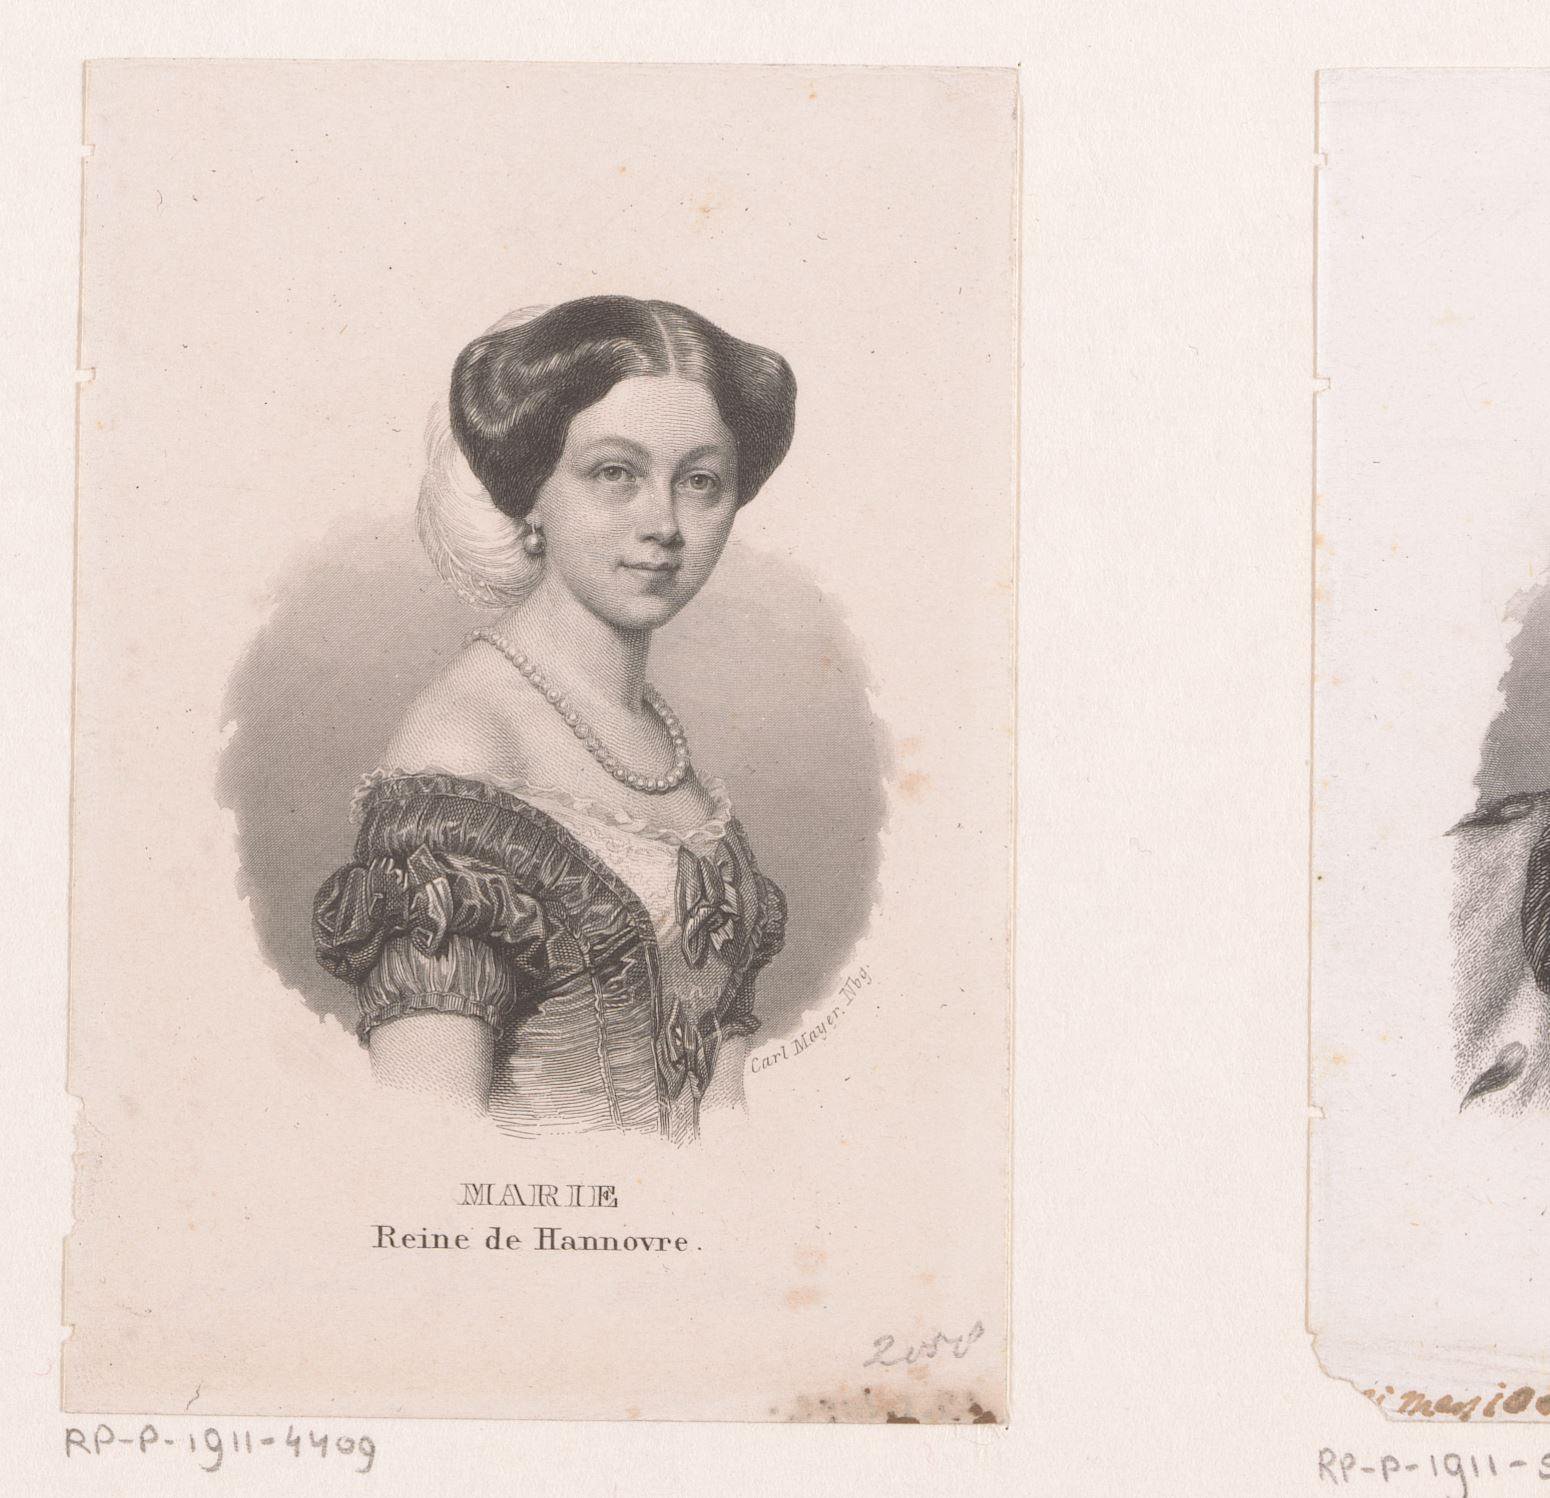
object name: print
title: Portret van koningin Marie van Hannover, geboren prinses van Saksen-Altenburg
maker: carl mayer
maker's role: print maker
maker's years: 1798-1868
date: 1818-1868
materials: paper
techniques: engraving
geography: nuremberg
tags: historical persons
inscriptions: collector's mark: Lugt 2228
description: Prent mogelijk afkomstig uit de Almanach de Gotha.